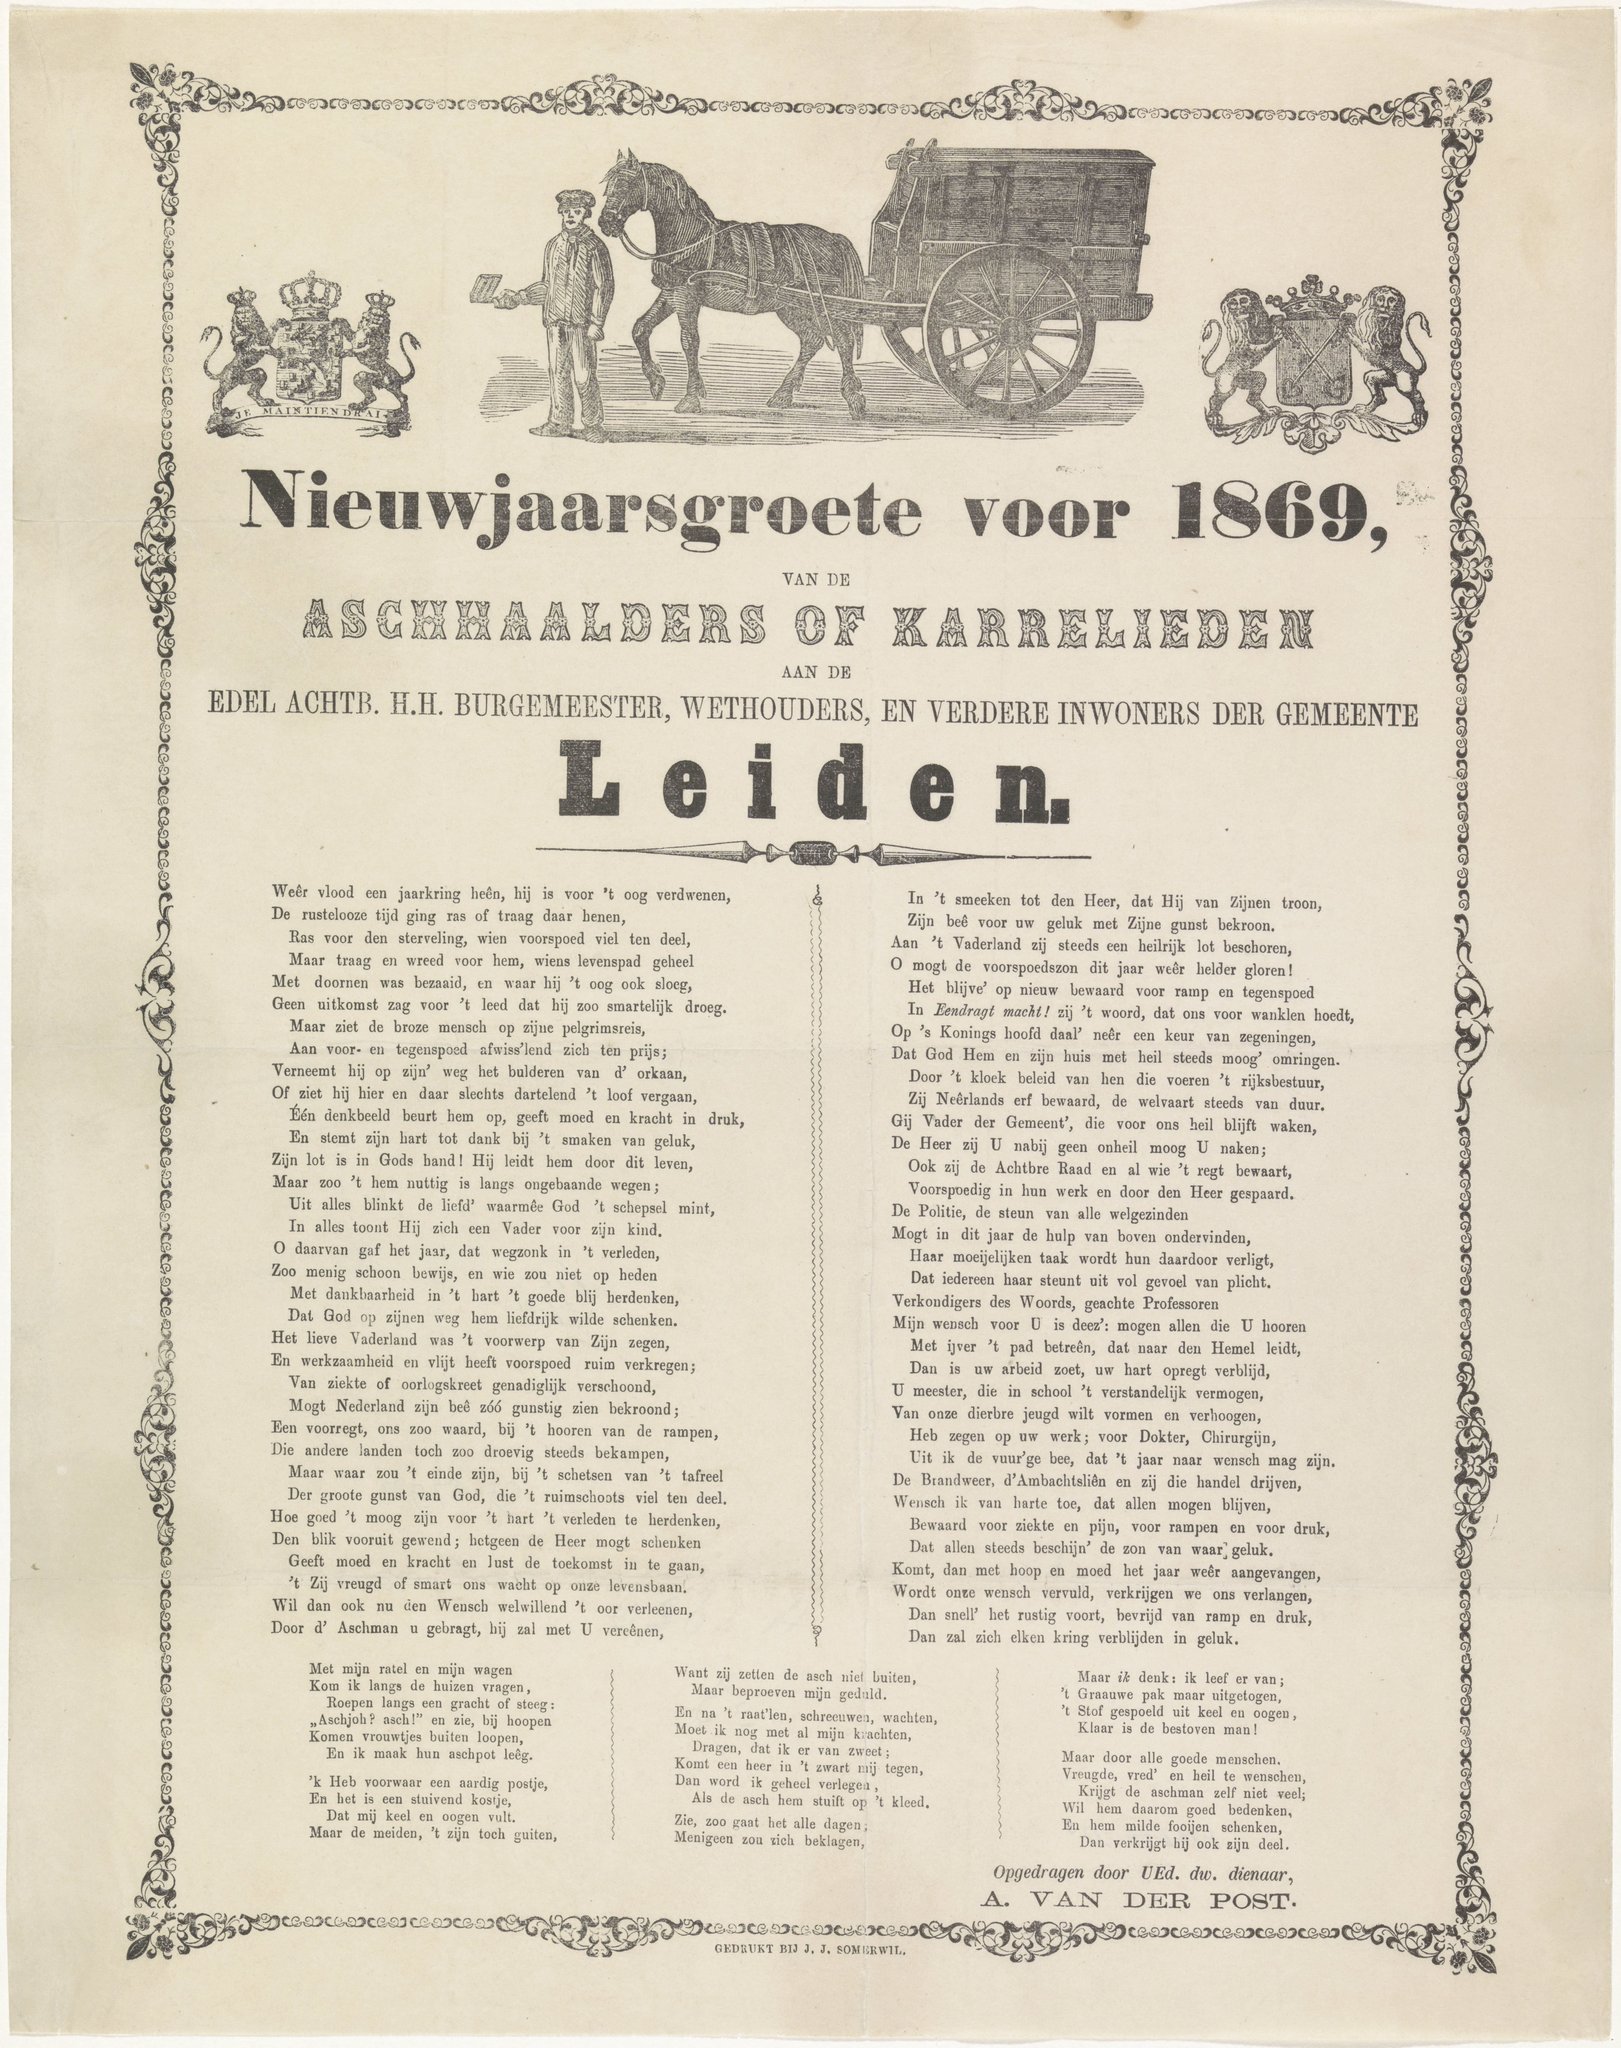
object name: print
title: Nieuwjaarswens van de Leidse askarrenmannen voor het jaar 1869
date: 1868-1869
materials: paper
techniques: letterpress printing, engraving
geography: netherlands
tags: garbage collection, leiden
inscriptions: collector's mark: Lugt 2228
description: Nieuwjaarswens namens de askarrenmannen (karrenman of vuilnisman) van Leiden voor het jaar 1869. Bovenaan drie vignetten met centraal een askarreman bij zijn kar, links en rechts wapens van Nederland en Leiden. Binnen een omlijsting van fileetwerk. Onderaan een vers in twee kolommen. Namens de askarreman: A. van der Post.